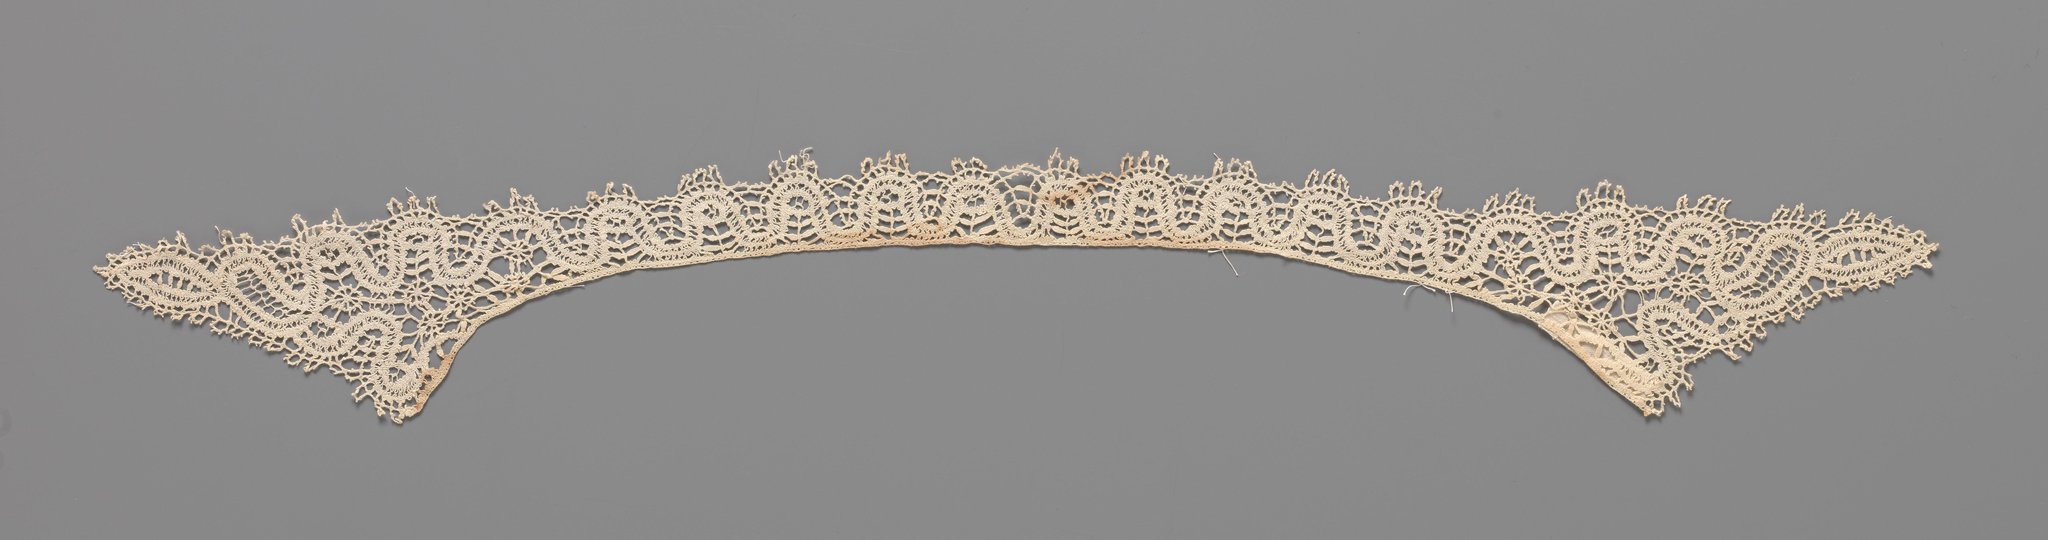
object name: womenswear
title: Kraag van kloskant met slingerband in vormslag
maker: Anonymous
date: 1850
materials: linen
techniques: lace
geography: france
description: Kraagje van naturelkleurige kloskant: Cluny-kant. Licht gebogen strookvormig model met scherpe punten aan de verbrede uiteinden. Patroon met een golvende band gevormd door dubbele linten geklost in linnenslag. In elk golfdal een hangt takje met blaadjes geklost in vormslag. Aan de uiteinden worden de slingerende linten met elkaar verbonden door wielen gemaakt met vlechtjes en blaadjes in vormslag.